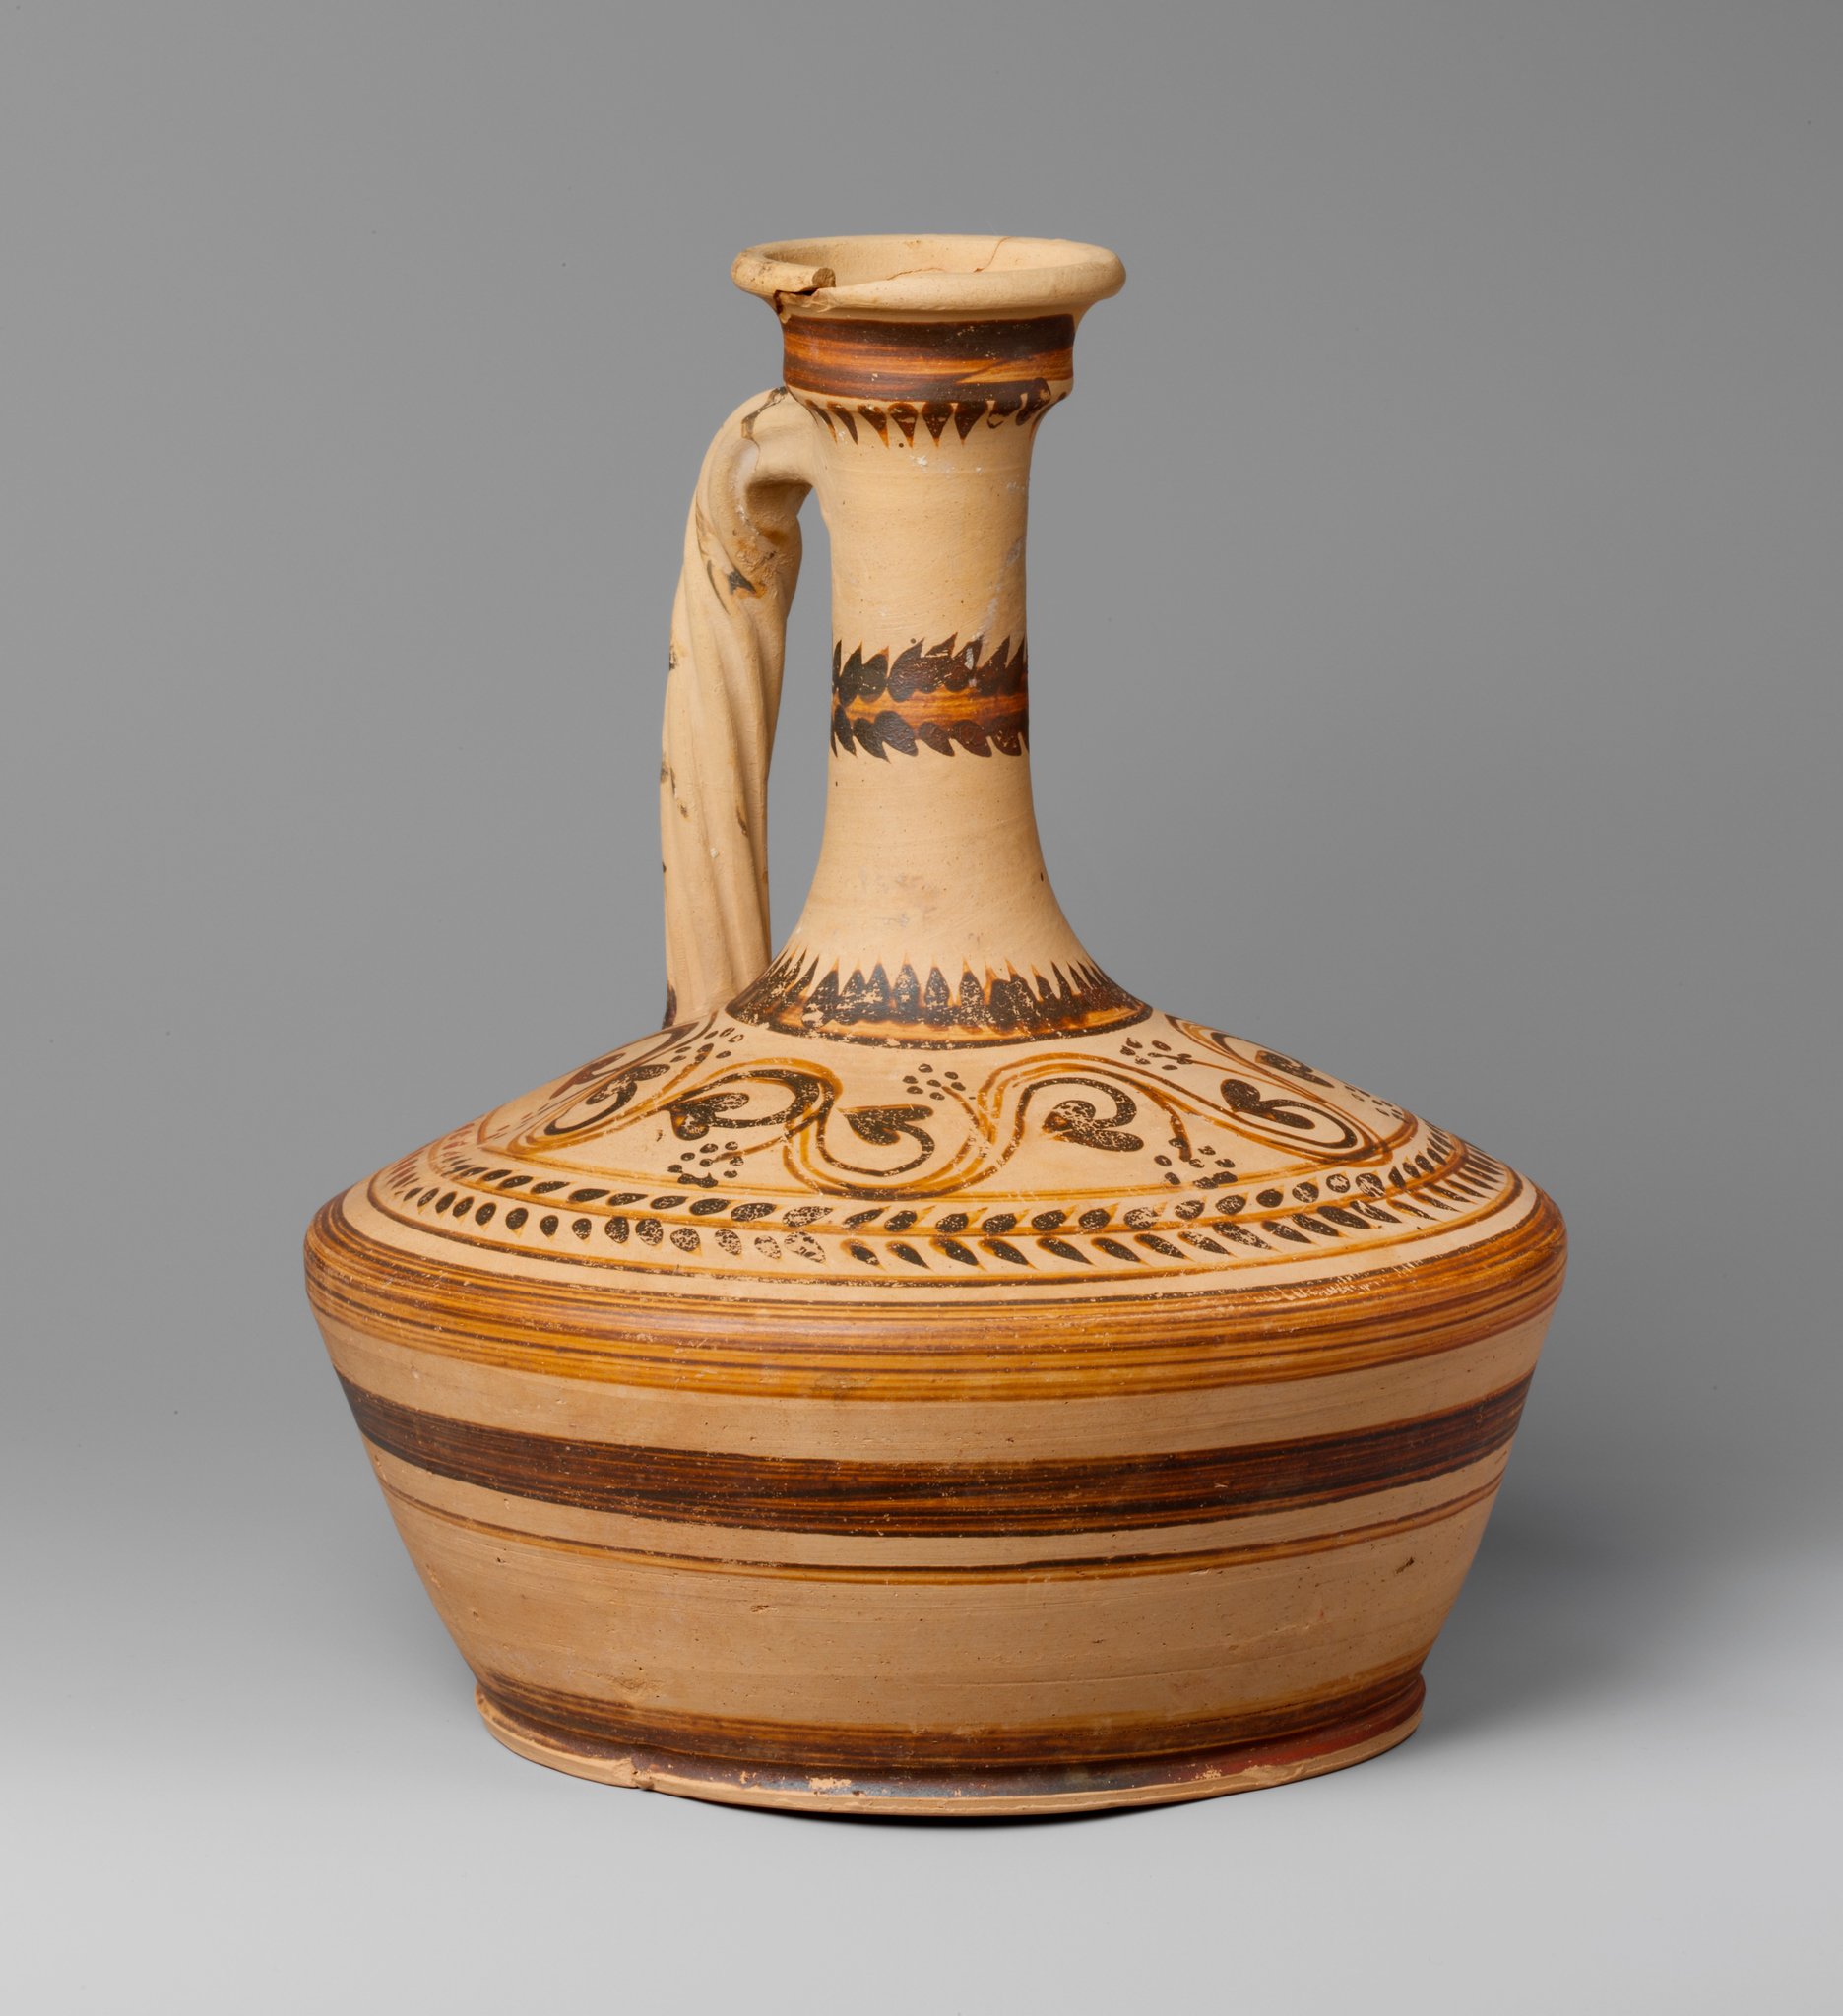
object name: lagynos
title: Terracotta lagynos (oil flask)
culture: cypriot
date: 150-50 BCE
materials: terracotta